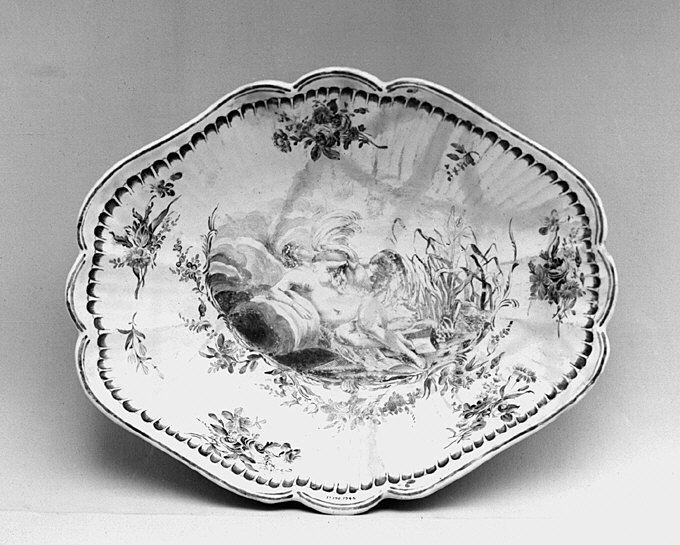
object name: basin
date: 1753-1795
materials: faience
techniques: glazing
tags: female nudes,plants